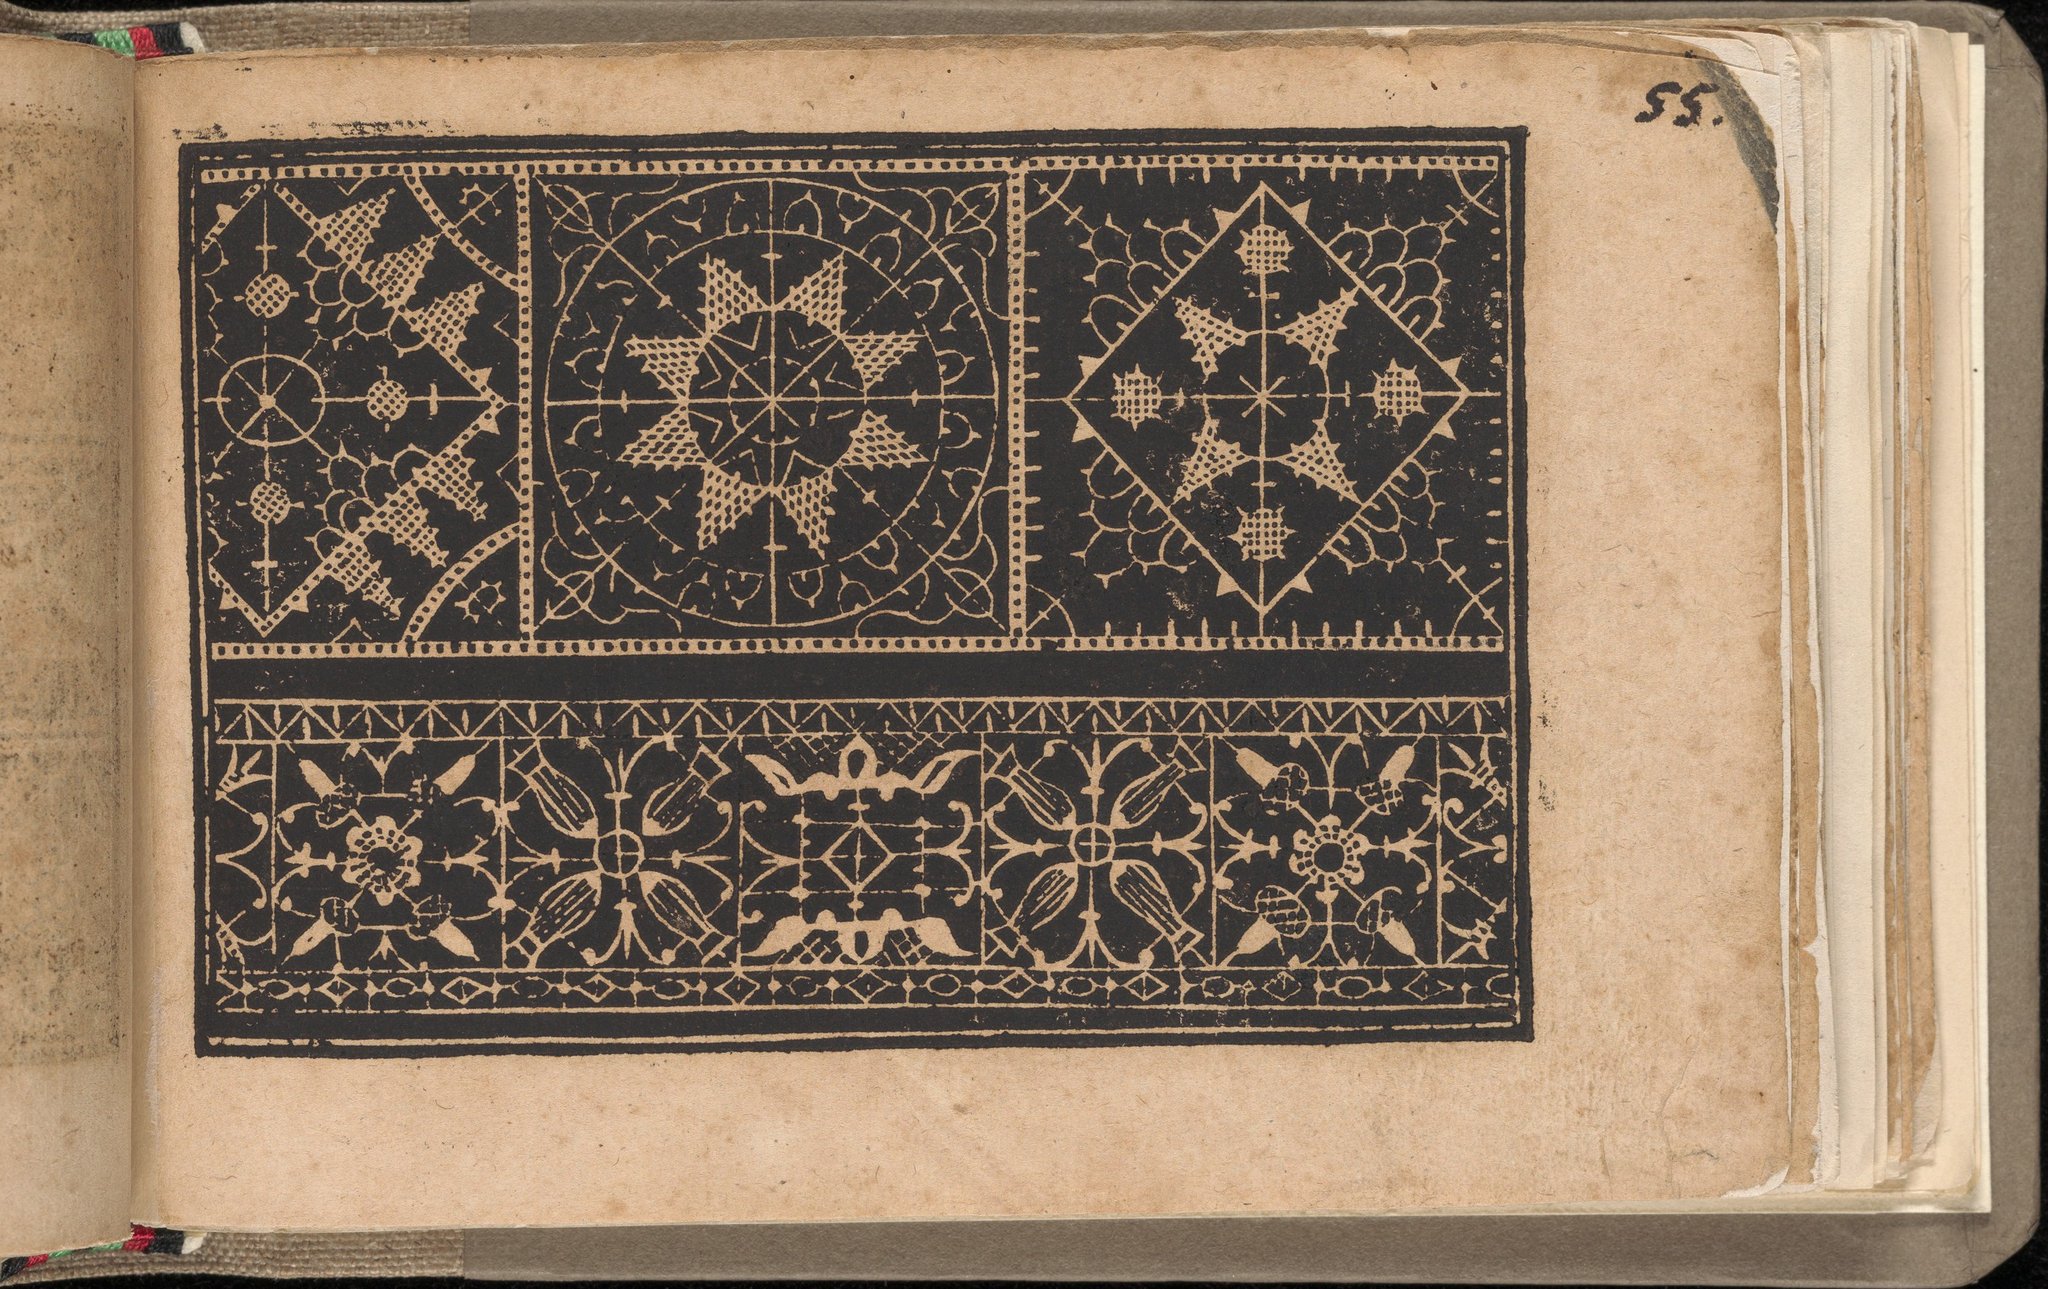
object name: book print ornament architecture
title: Schön newes Modelbuch (Page 55r)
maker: sigismundus latomus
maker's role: publisher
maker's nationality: german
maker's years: 1599-1632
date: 1608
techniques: woodcut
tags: ornament